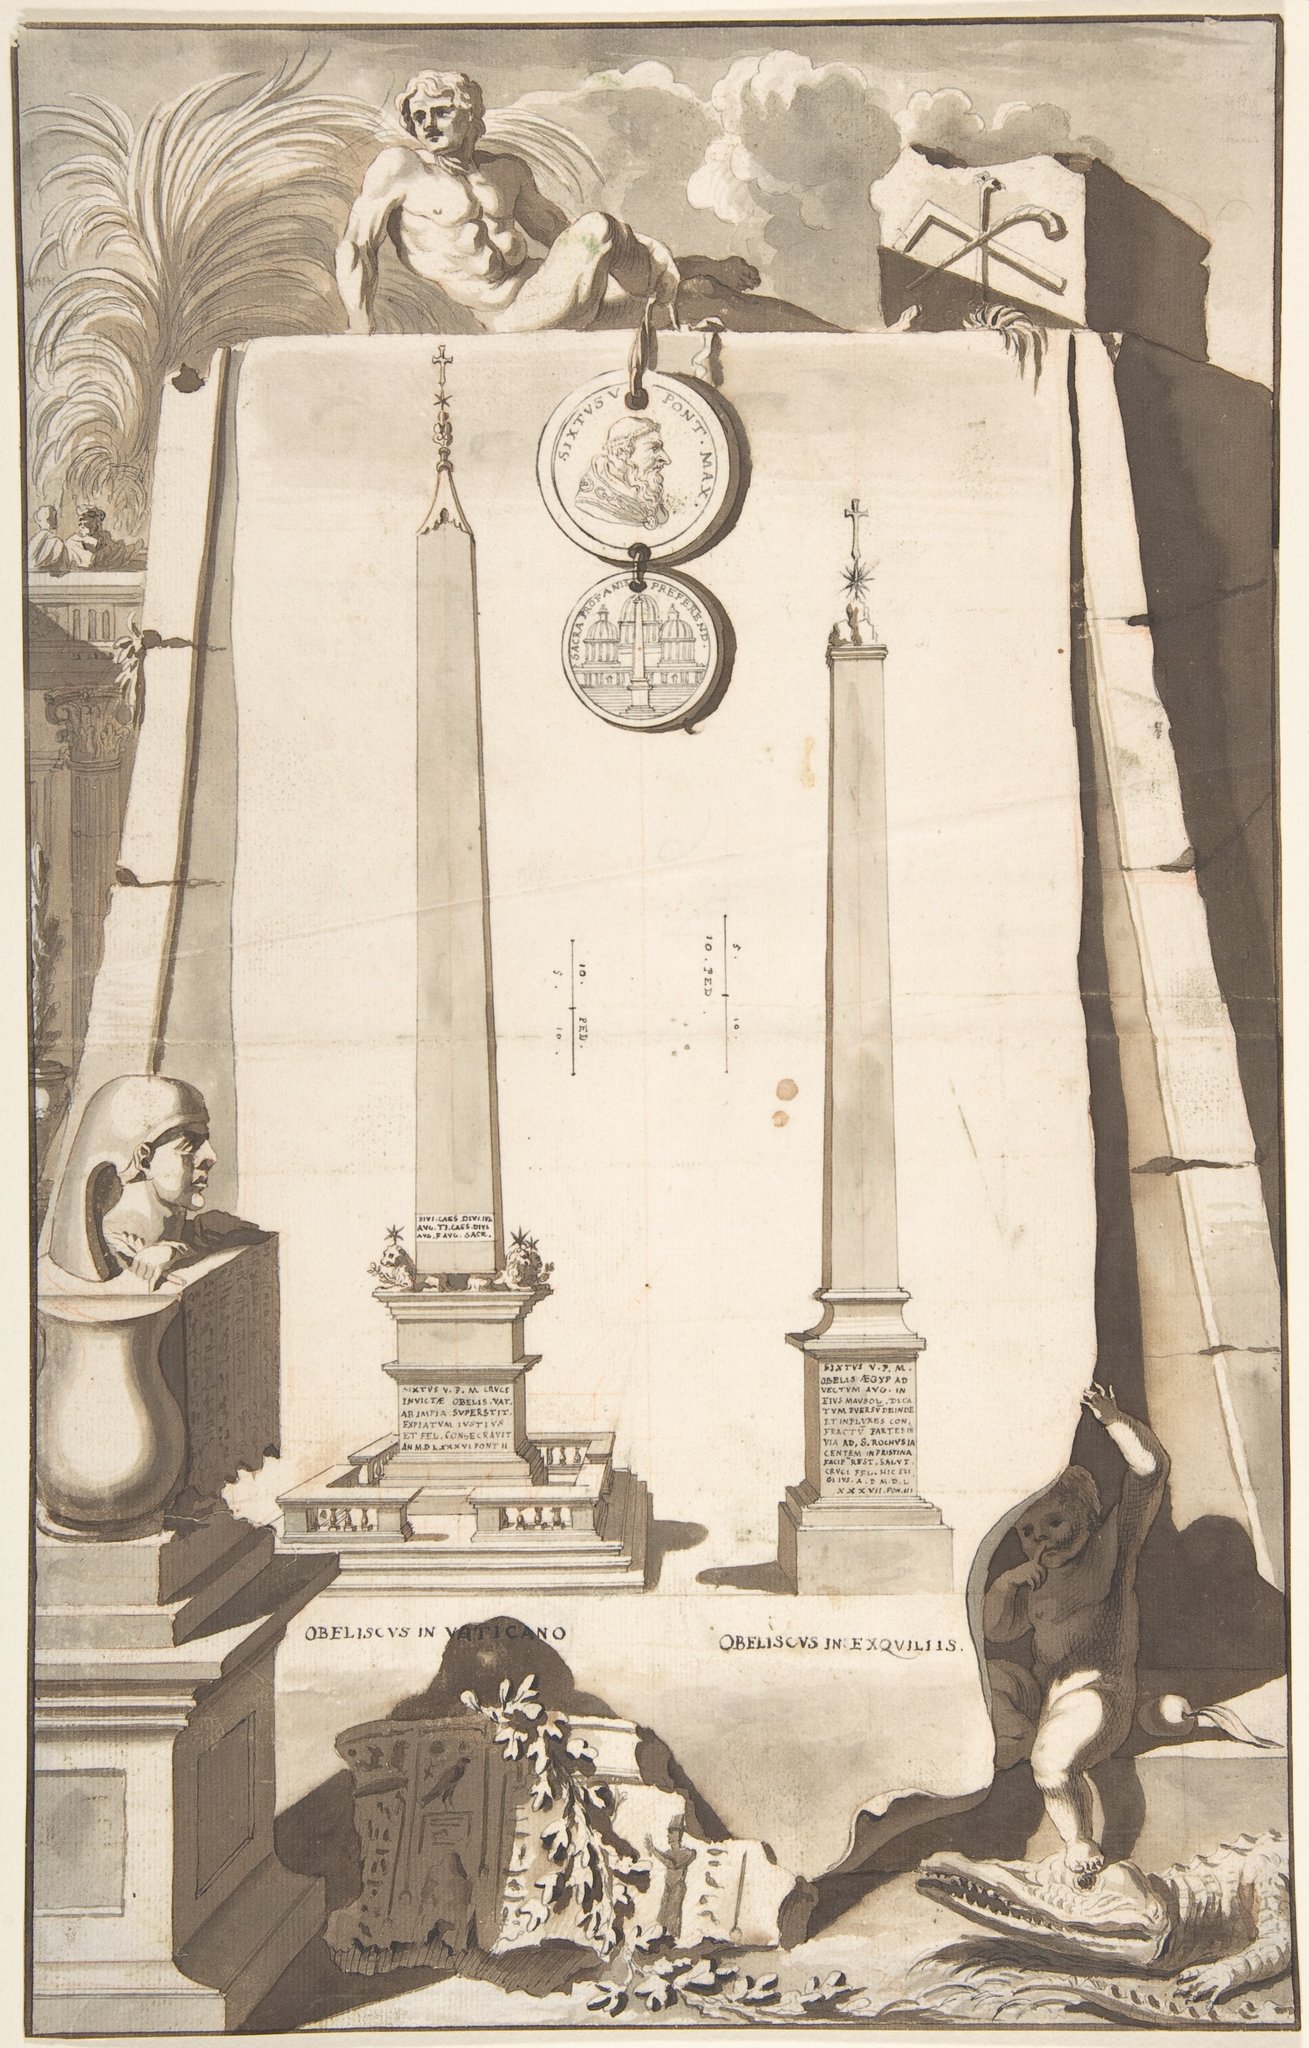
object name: drawing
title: A View of Two Obelisks, One in the Vatican and the Other on the Esqualine Hill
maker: jan goeree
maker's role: artist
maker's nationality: dutch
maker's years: 1670-1731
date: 1704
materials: chalk, ink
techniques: brush, incising, pen, wash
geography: italy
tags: obelisks,children,male nudes,crocodiles